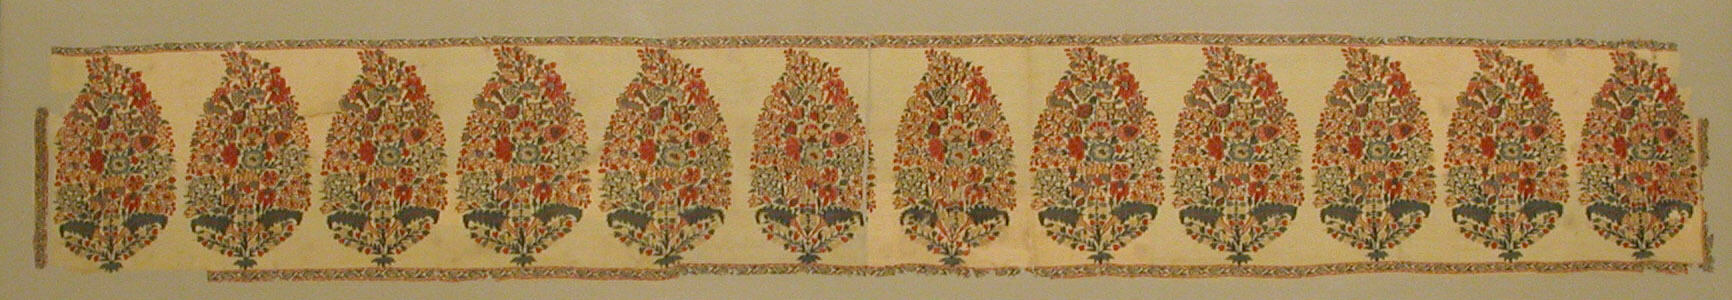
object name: panel from a shawl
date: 1701-1750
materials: wool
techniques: interlocking, weave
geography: india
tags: flowers